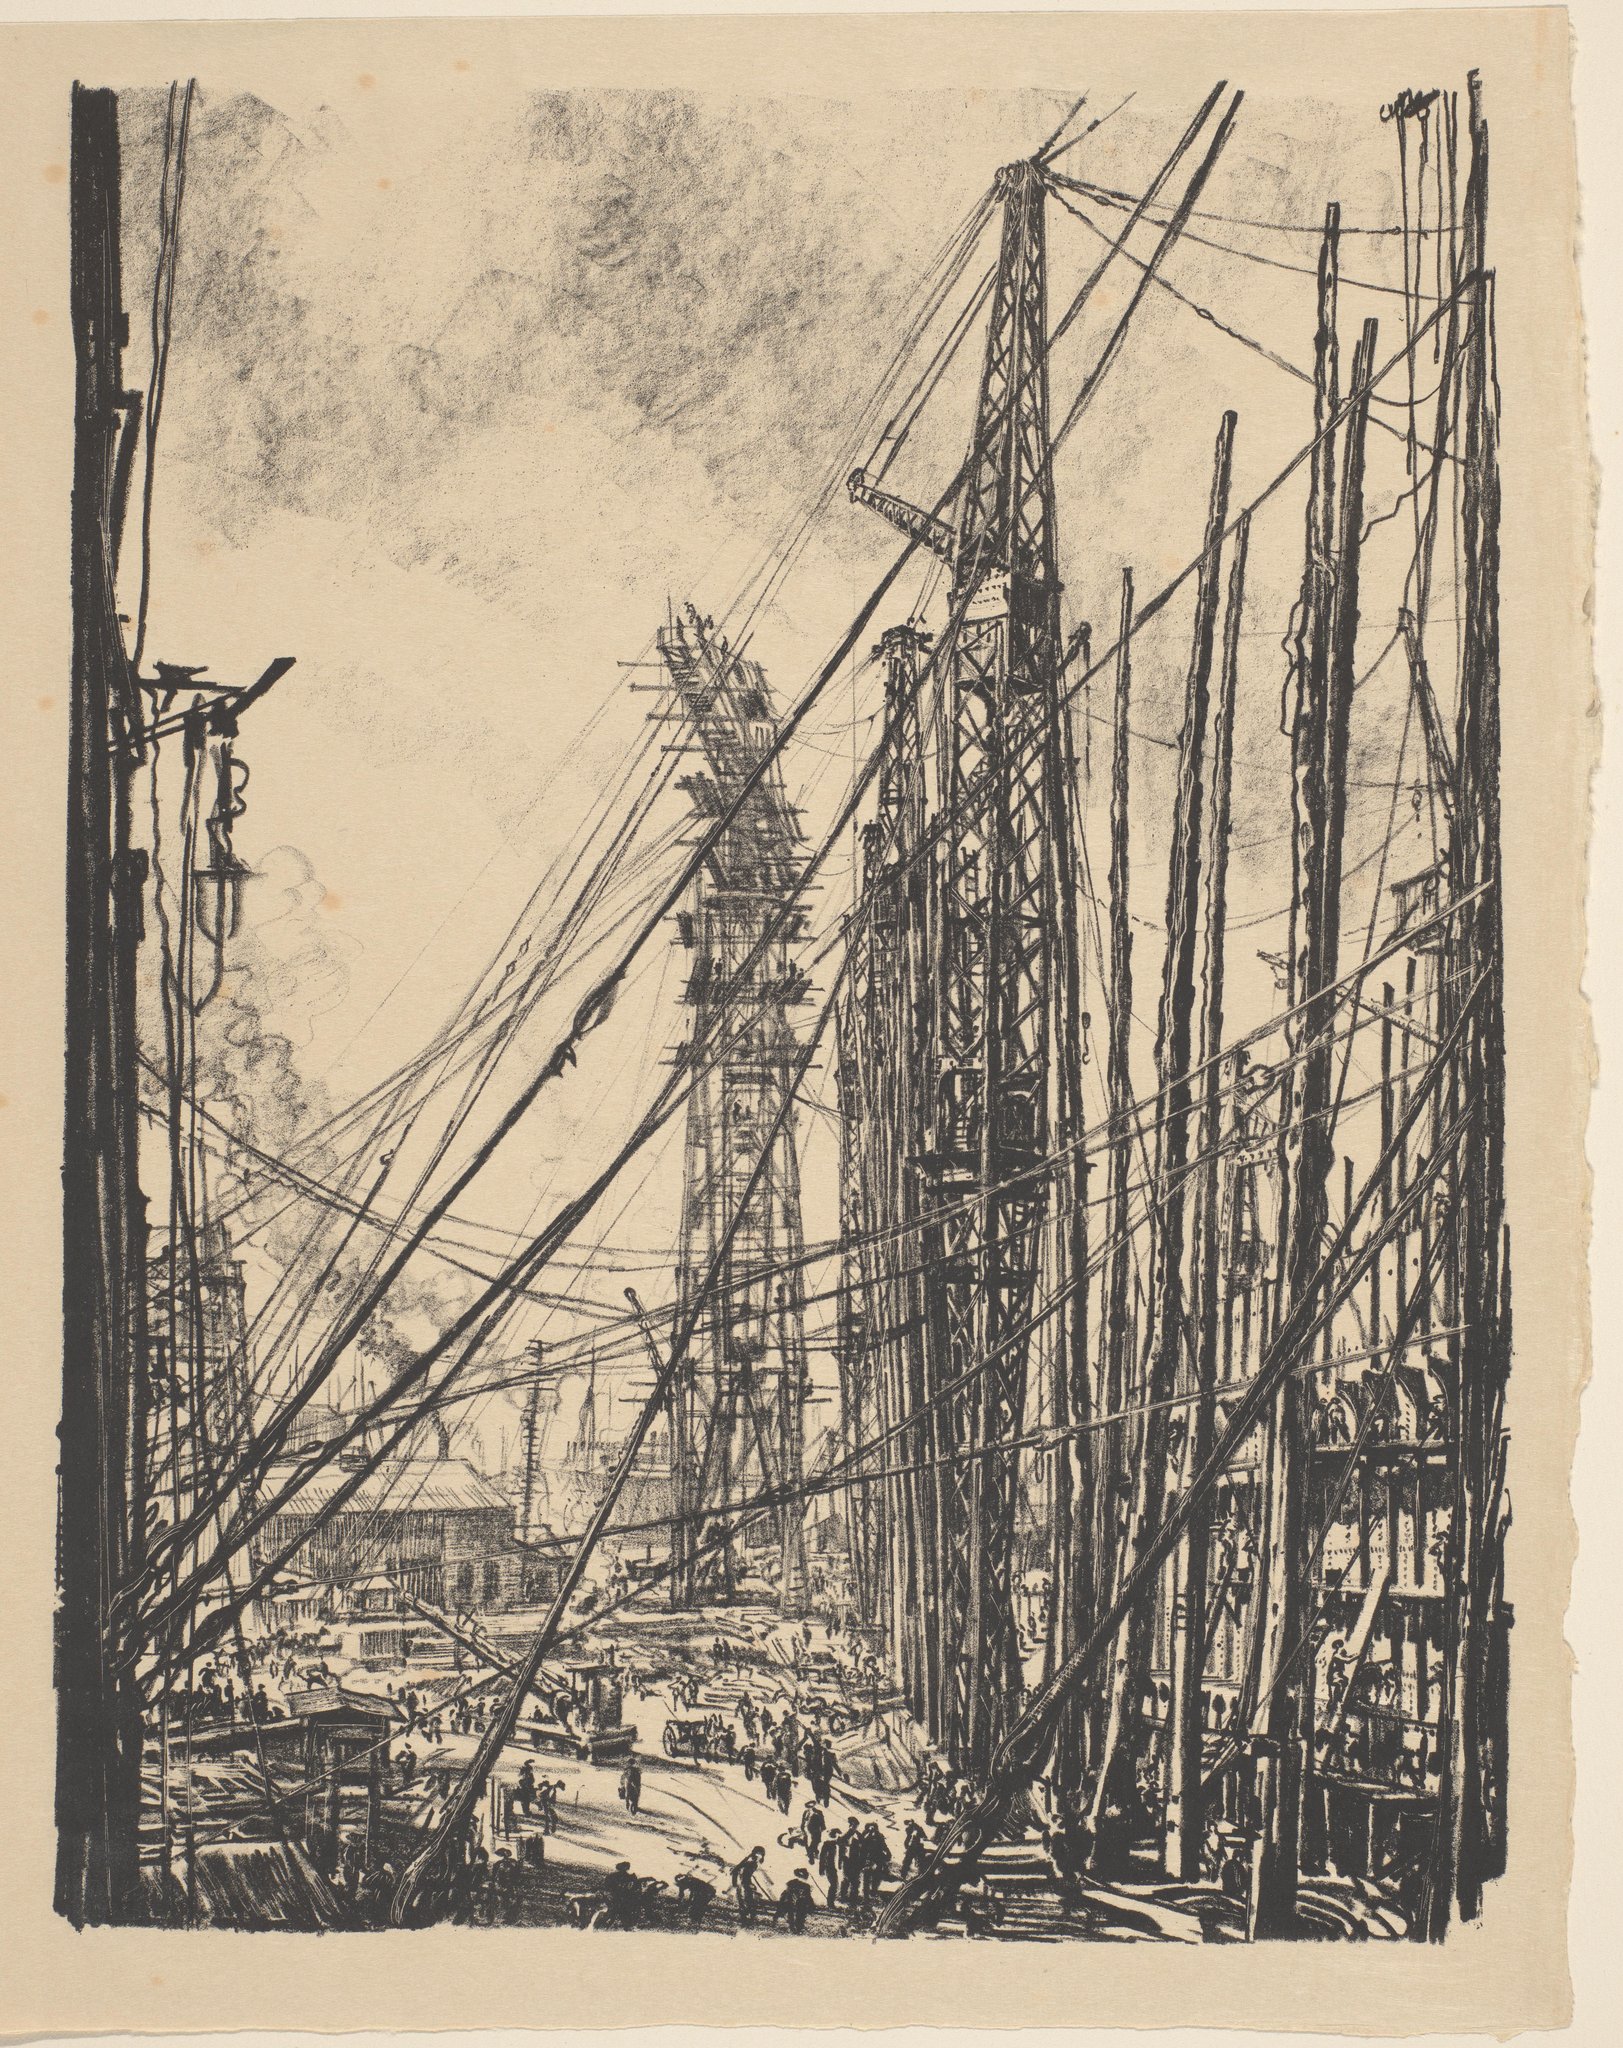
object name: print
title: Scheepswerf met kranen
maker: muirhead bone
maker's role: artist, print maker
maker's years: 1876-1953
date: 1916-1917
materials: paper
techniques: lithograph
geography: england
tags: ships (in general), harbour equipment, building-site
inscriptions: watermark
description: Deze prent behoort tot de reeks 'Building Ships' binnen de serie 'The Great War: Britain’s Efforts and Ideals'.